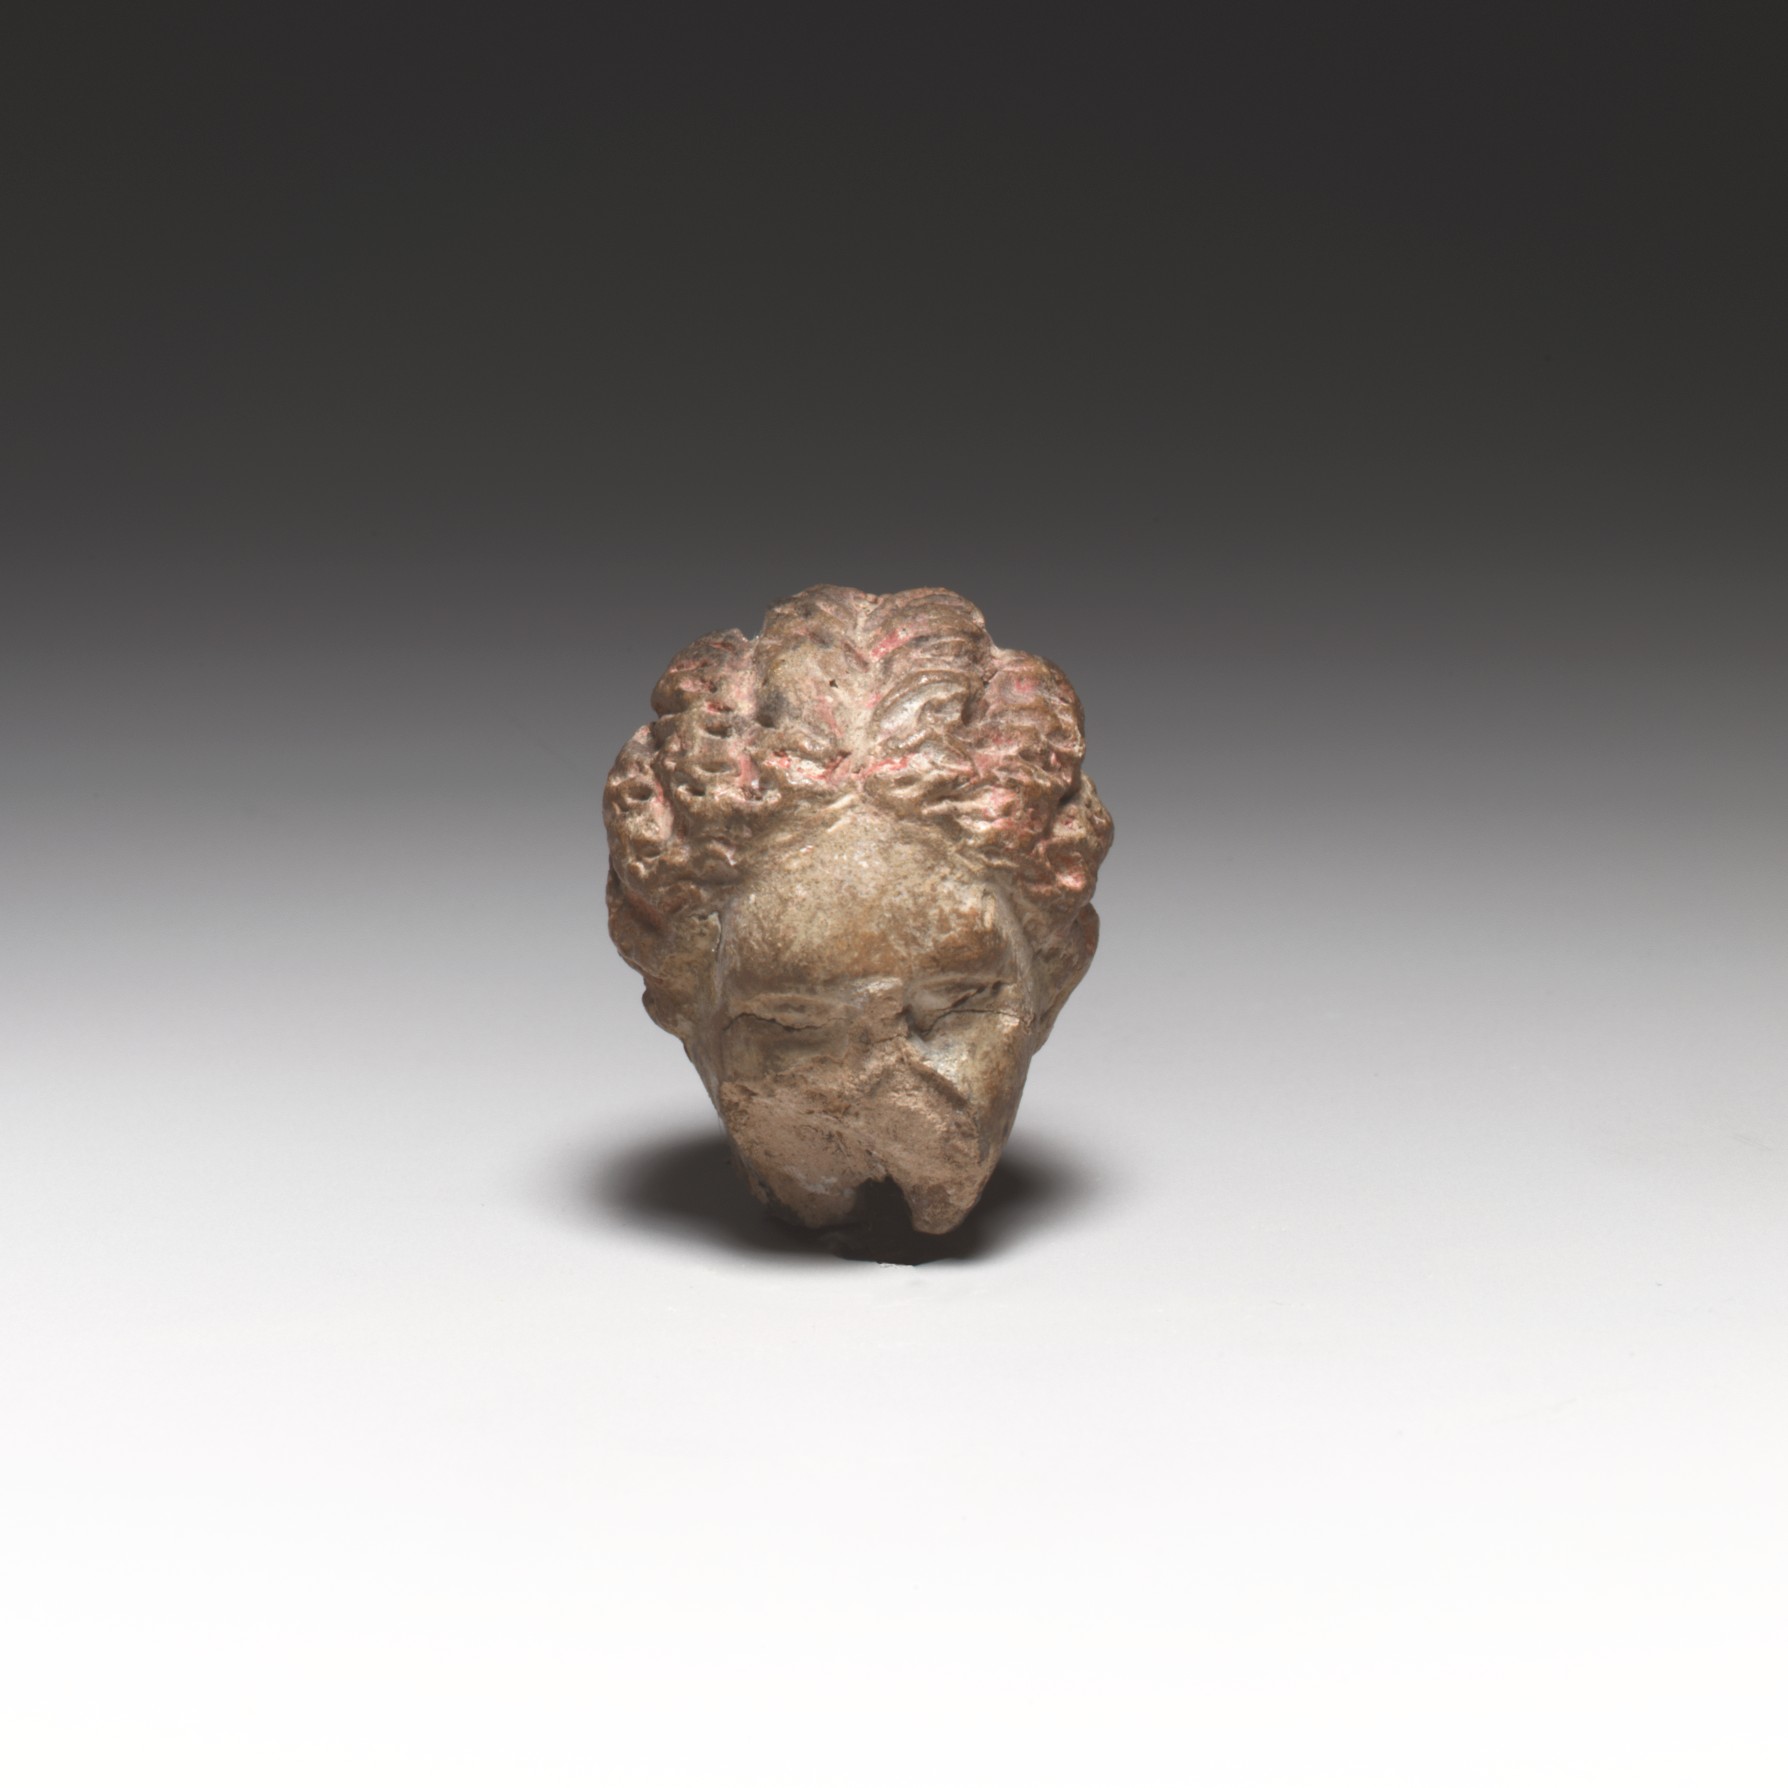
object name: head of a woman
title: Female head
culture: cypriot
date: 300-201 BCE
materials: terracotta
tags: heads